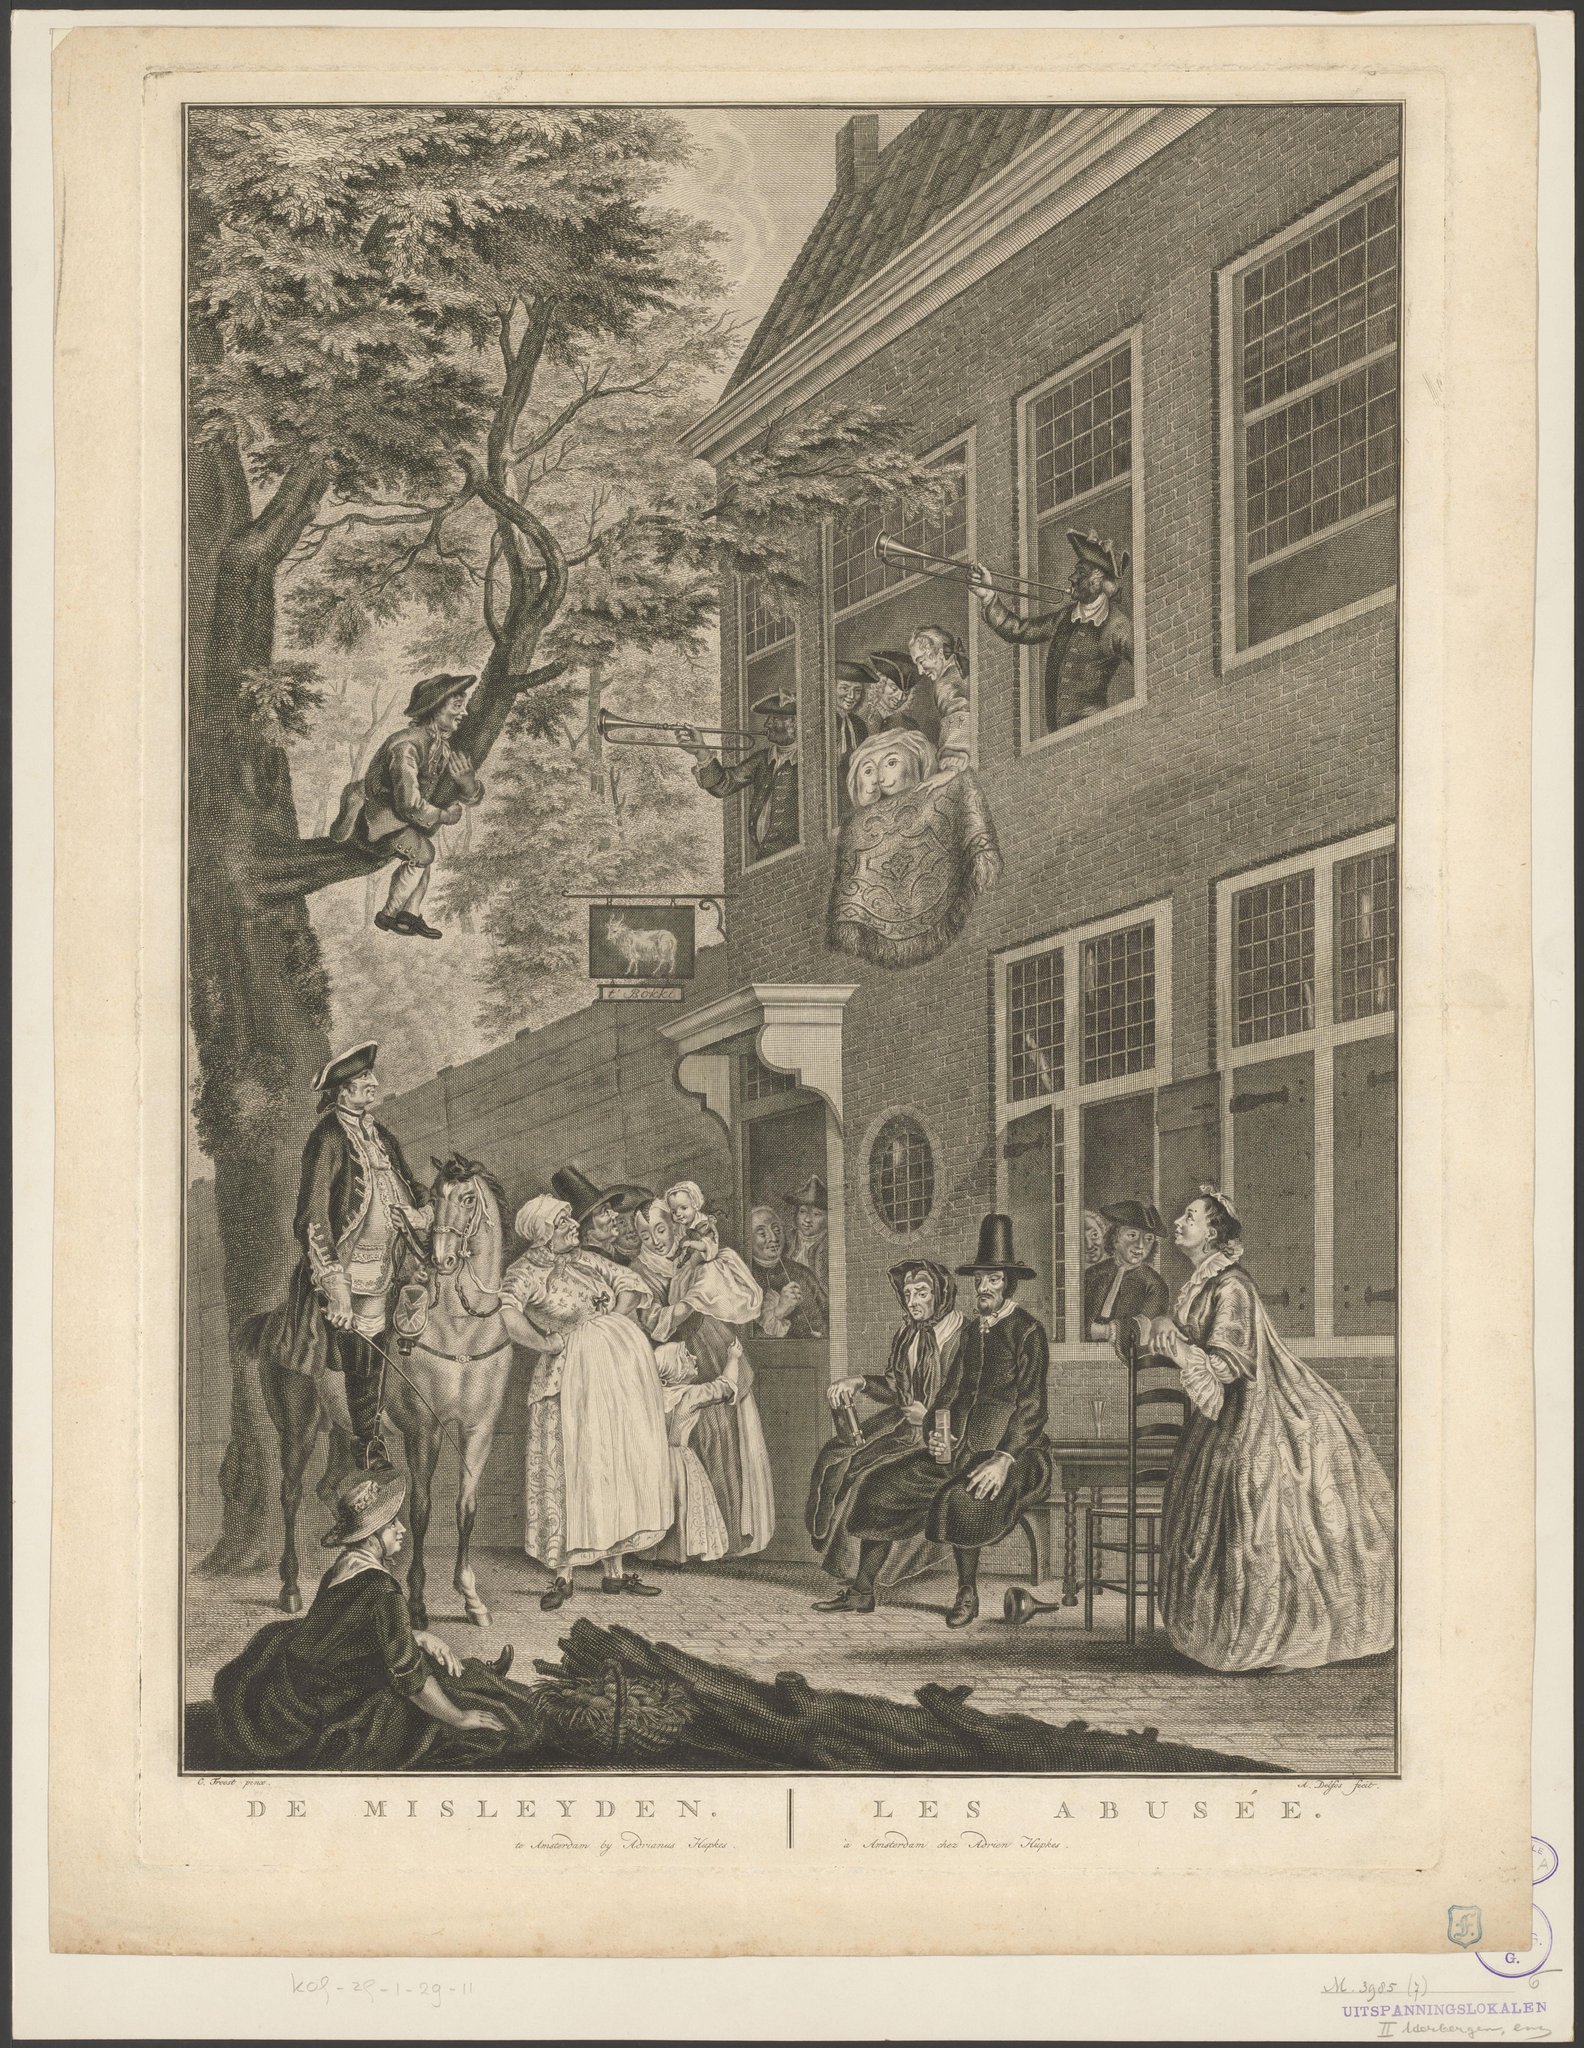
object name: print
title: De misleyden: de ambassadeur der Labberlotten vertoont zich voor het venster van de herberg 't Bokki in de Haarlemmerhout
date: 1758-1773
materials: paper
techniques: engraving, etching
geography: amsterdam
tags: mocking, insulting; teasing, hotel, hostelry, inn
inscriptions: collector's mark: Lugt 963, stamp, stamp, collector's mark: Lugt 1641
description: De misleyden: de ambassadeur der Labberlotten vertoont zich voor het venster van de herberg 't Bokki in de Haarlemmerhout (een grap bedreven door Jacob Campo Weyerman en consorten). Een groep mensen kijkt naar het als een gezicht beschilderde achterwerk van een man, uit het venster van de herberg gestoken. Aan weerszijden twee trompetters met zwart geverfde gezichten. Voor de herberg zitten een in zwart geklede man en vrouw, bijbels in de hand. Onderwerpsrubrieken binnen de Atlas Zeden en Gewoonten: Zeden en gewoonten in engeren zin, Volksleven, Uitspanningslokalen, Herbergen.